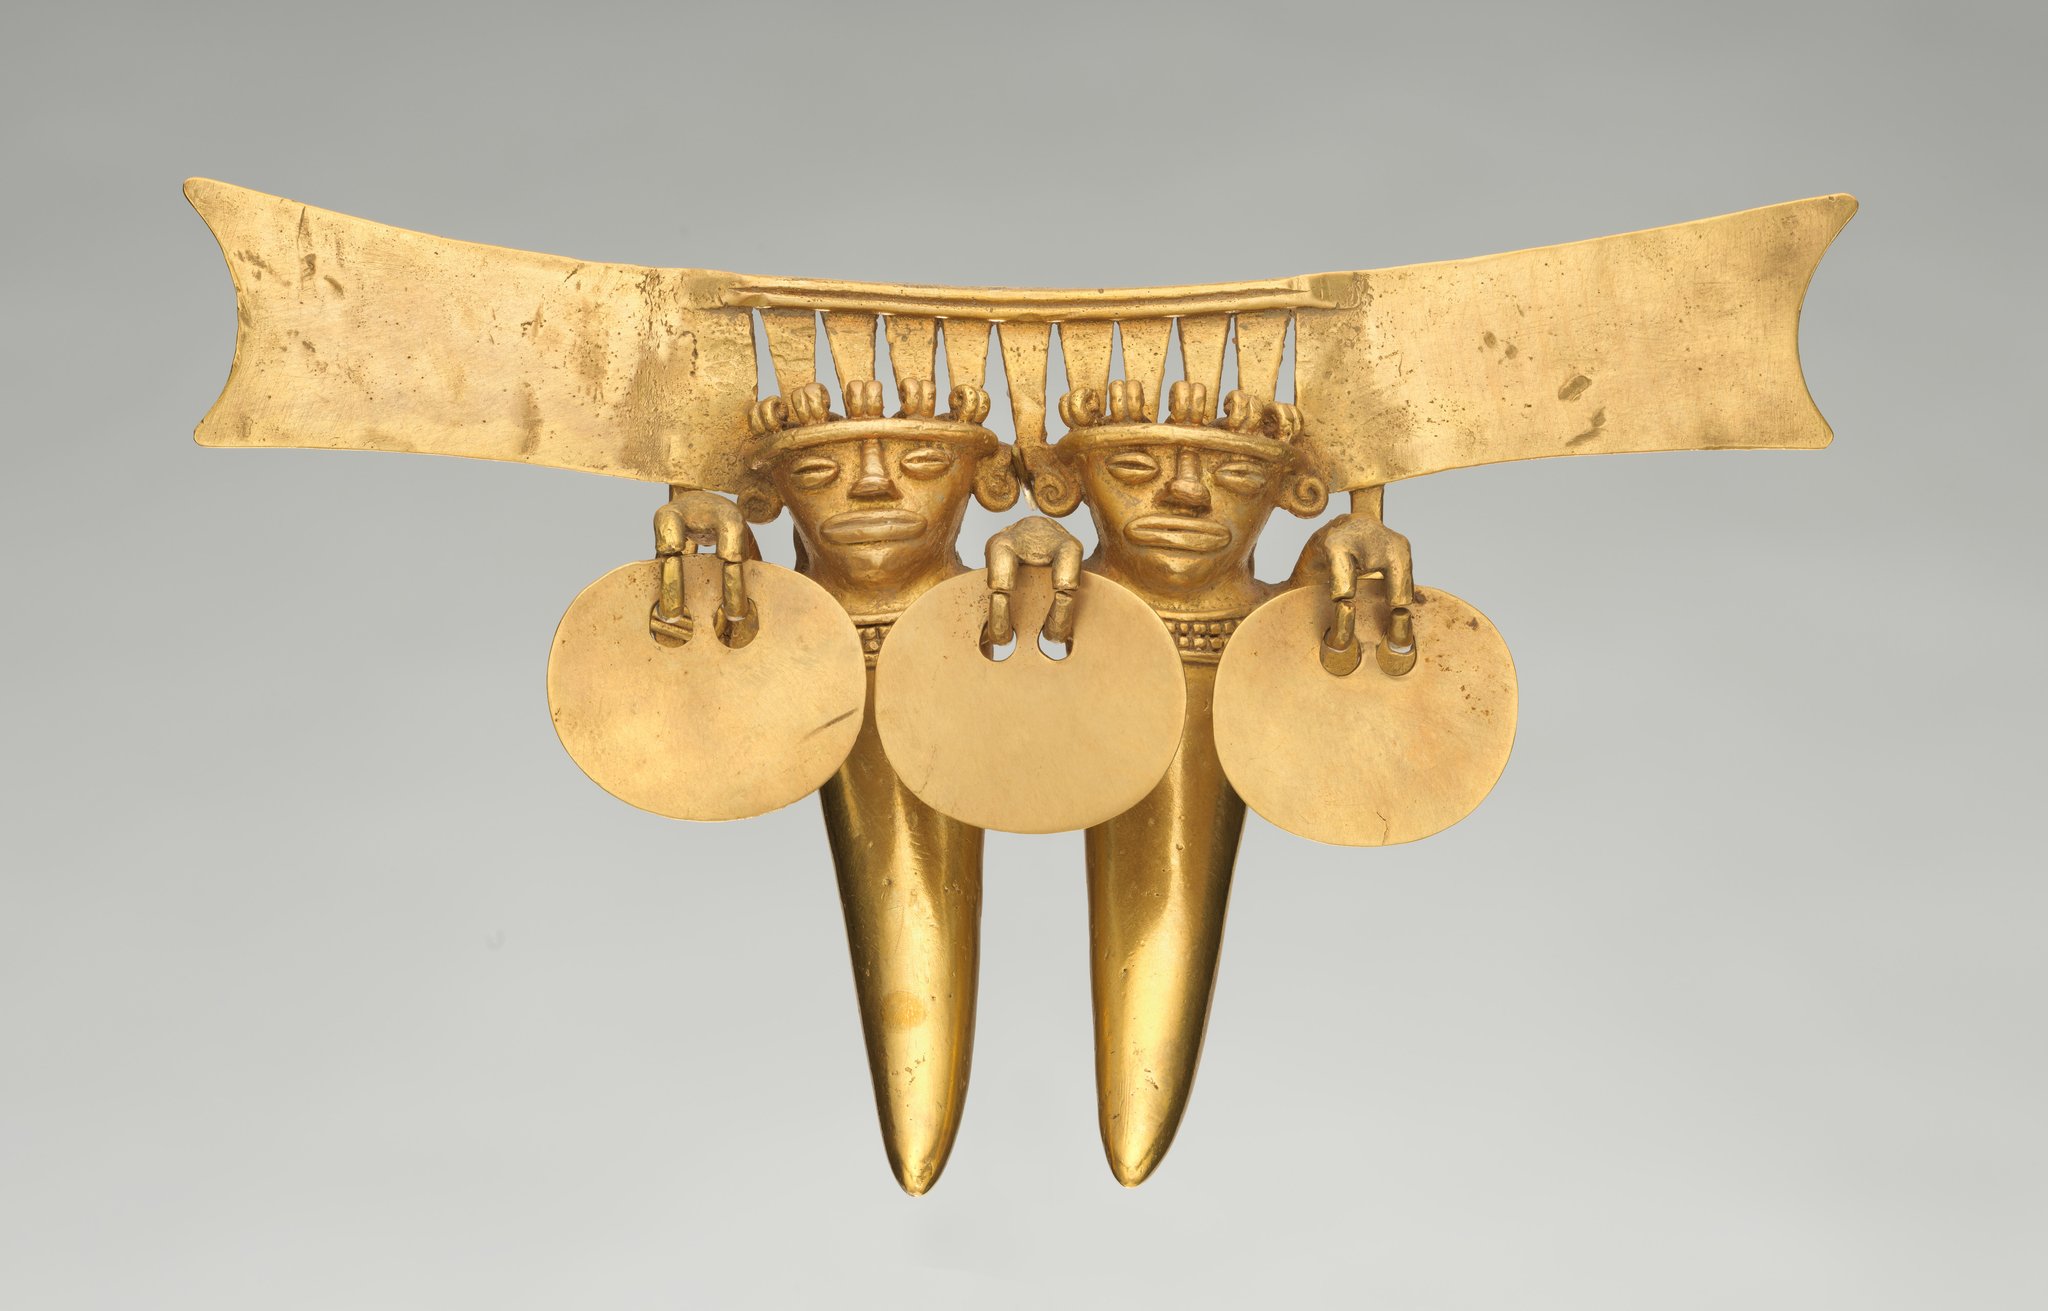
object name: pendant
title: Double Figure Pendant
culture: chiriqui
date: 1001-1600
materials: gold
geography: costa rica